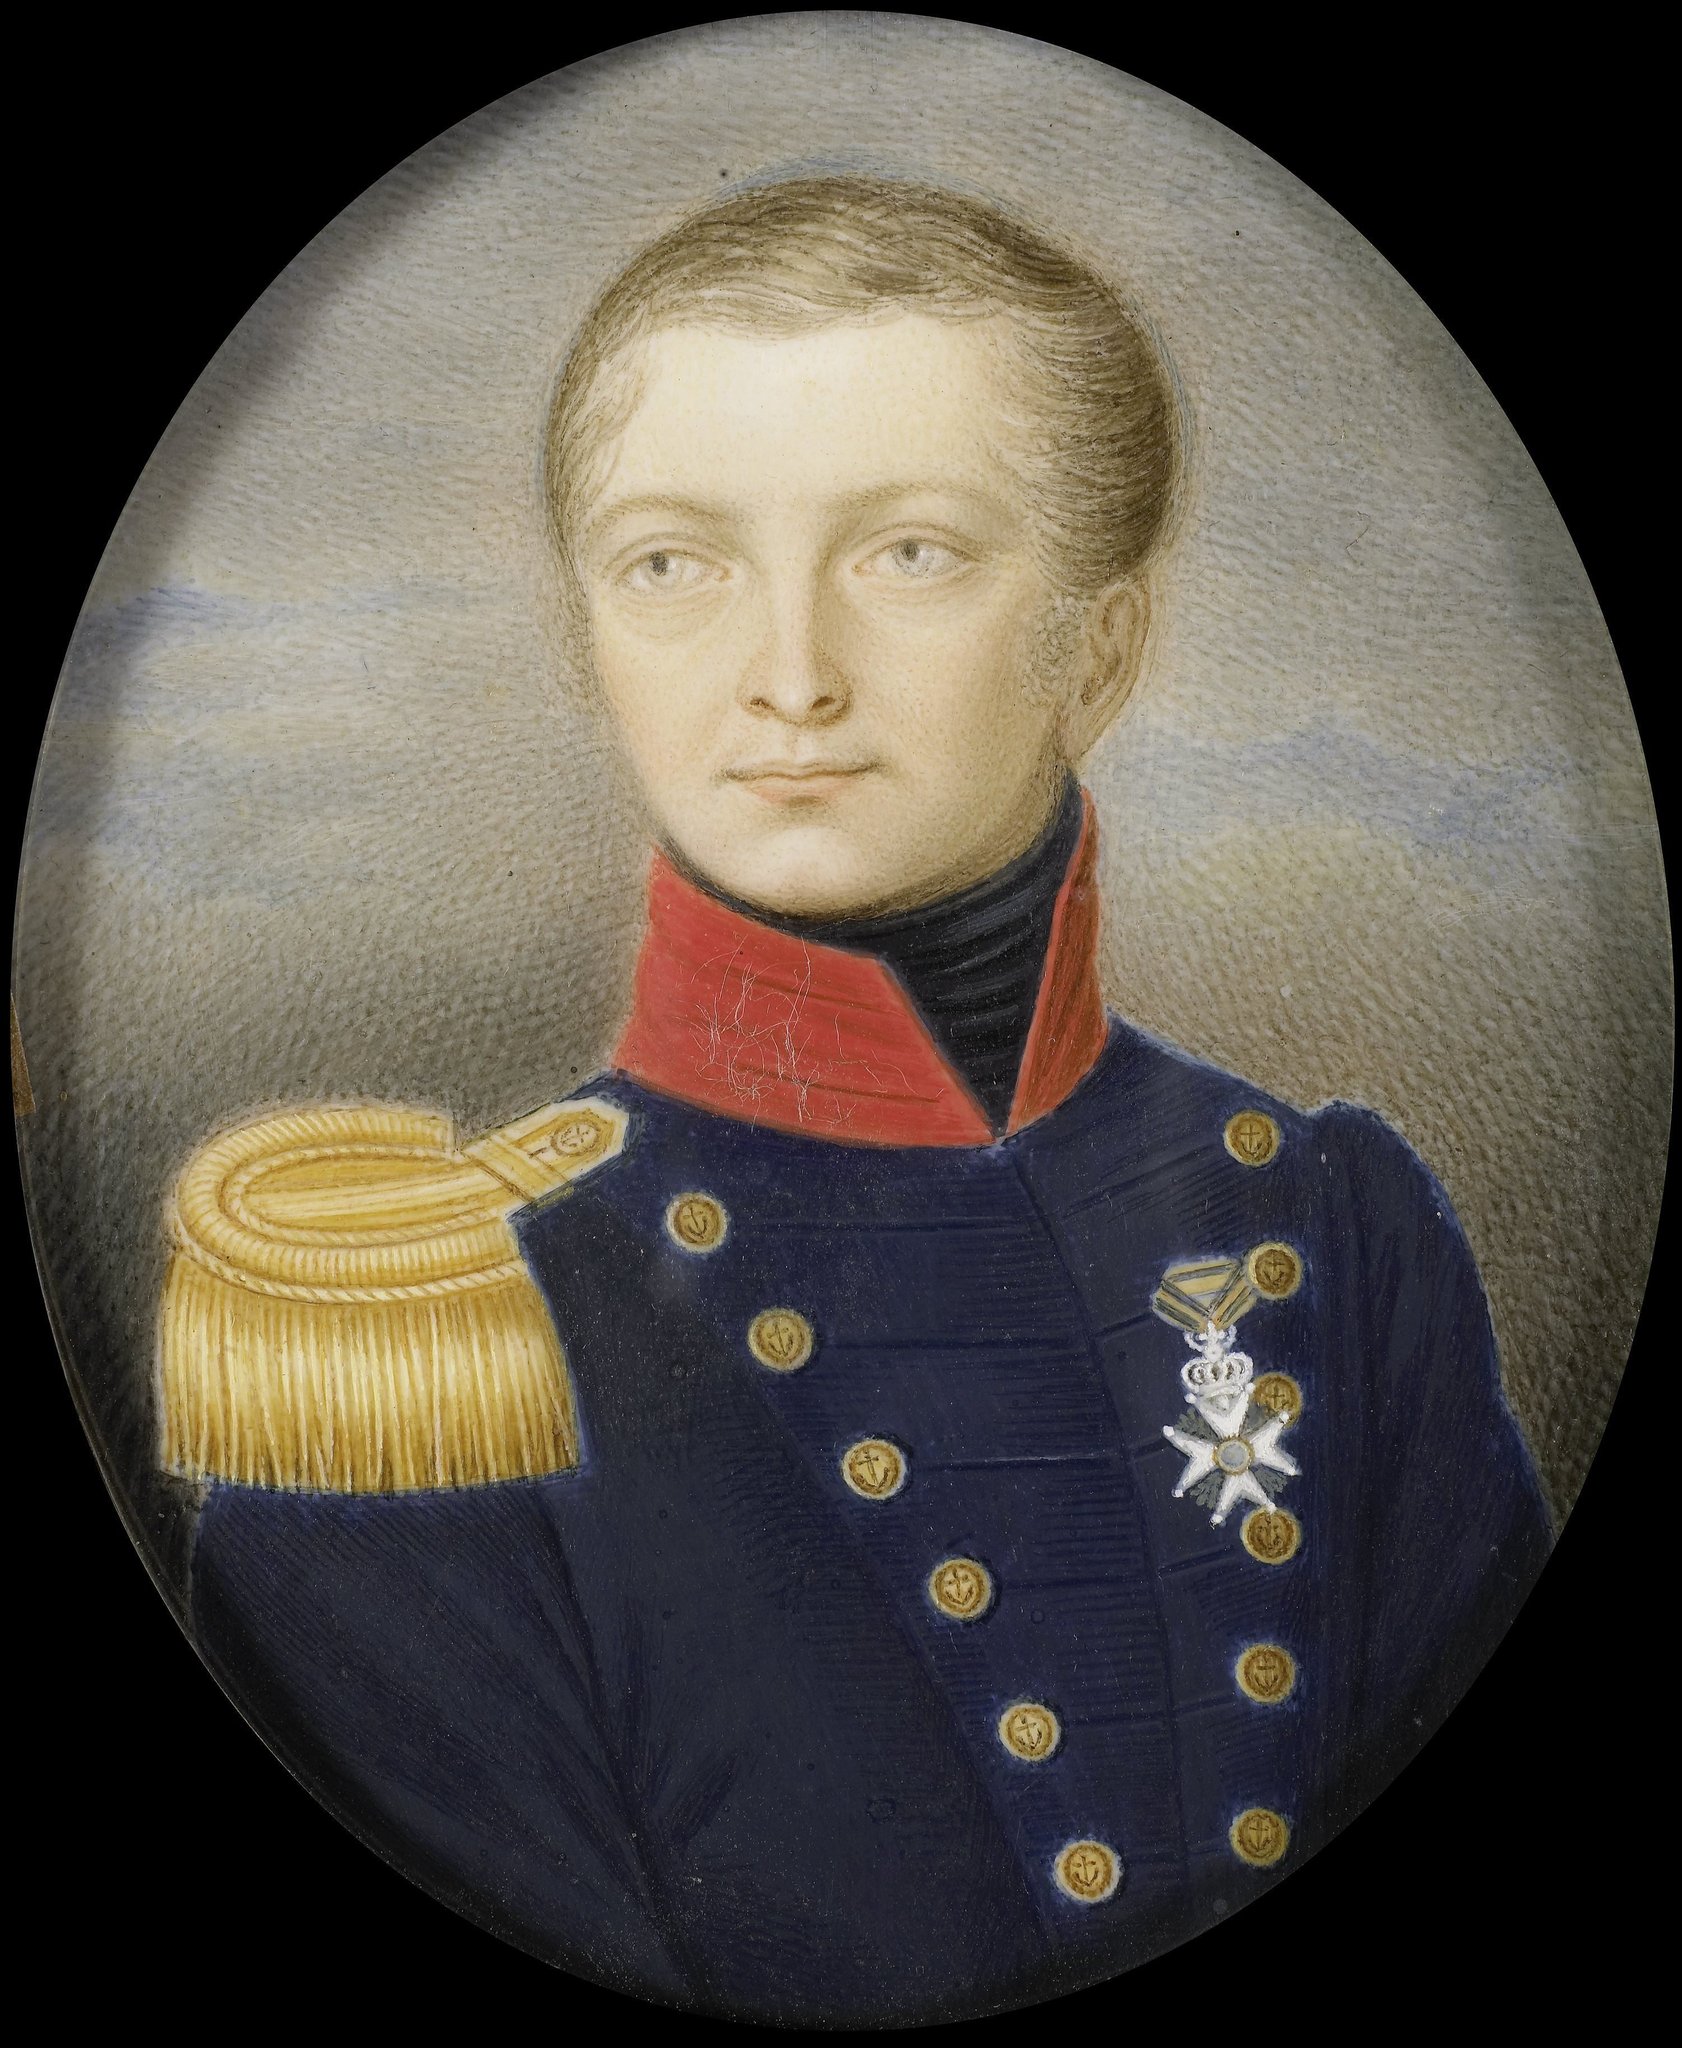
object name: painting, miniature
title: Jan Carel Josephus van Speyk (1802-31). Zeeofficier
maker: joannes antonius augustinus pluckx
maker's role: print maker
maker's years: 1786-1837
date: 1820-1837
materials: glass, ivory, metal, wood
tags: antwerp, jan van speyk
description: Portret van Jan Carel Josephus van Speyk (1802-31). Zeeofficier. Buste, het hoofd naar links gekeerd, in uniform. Onderdeel van de collectie portretminiaturen.